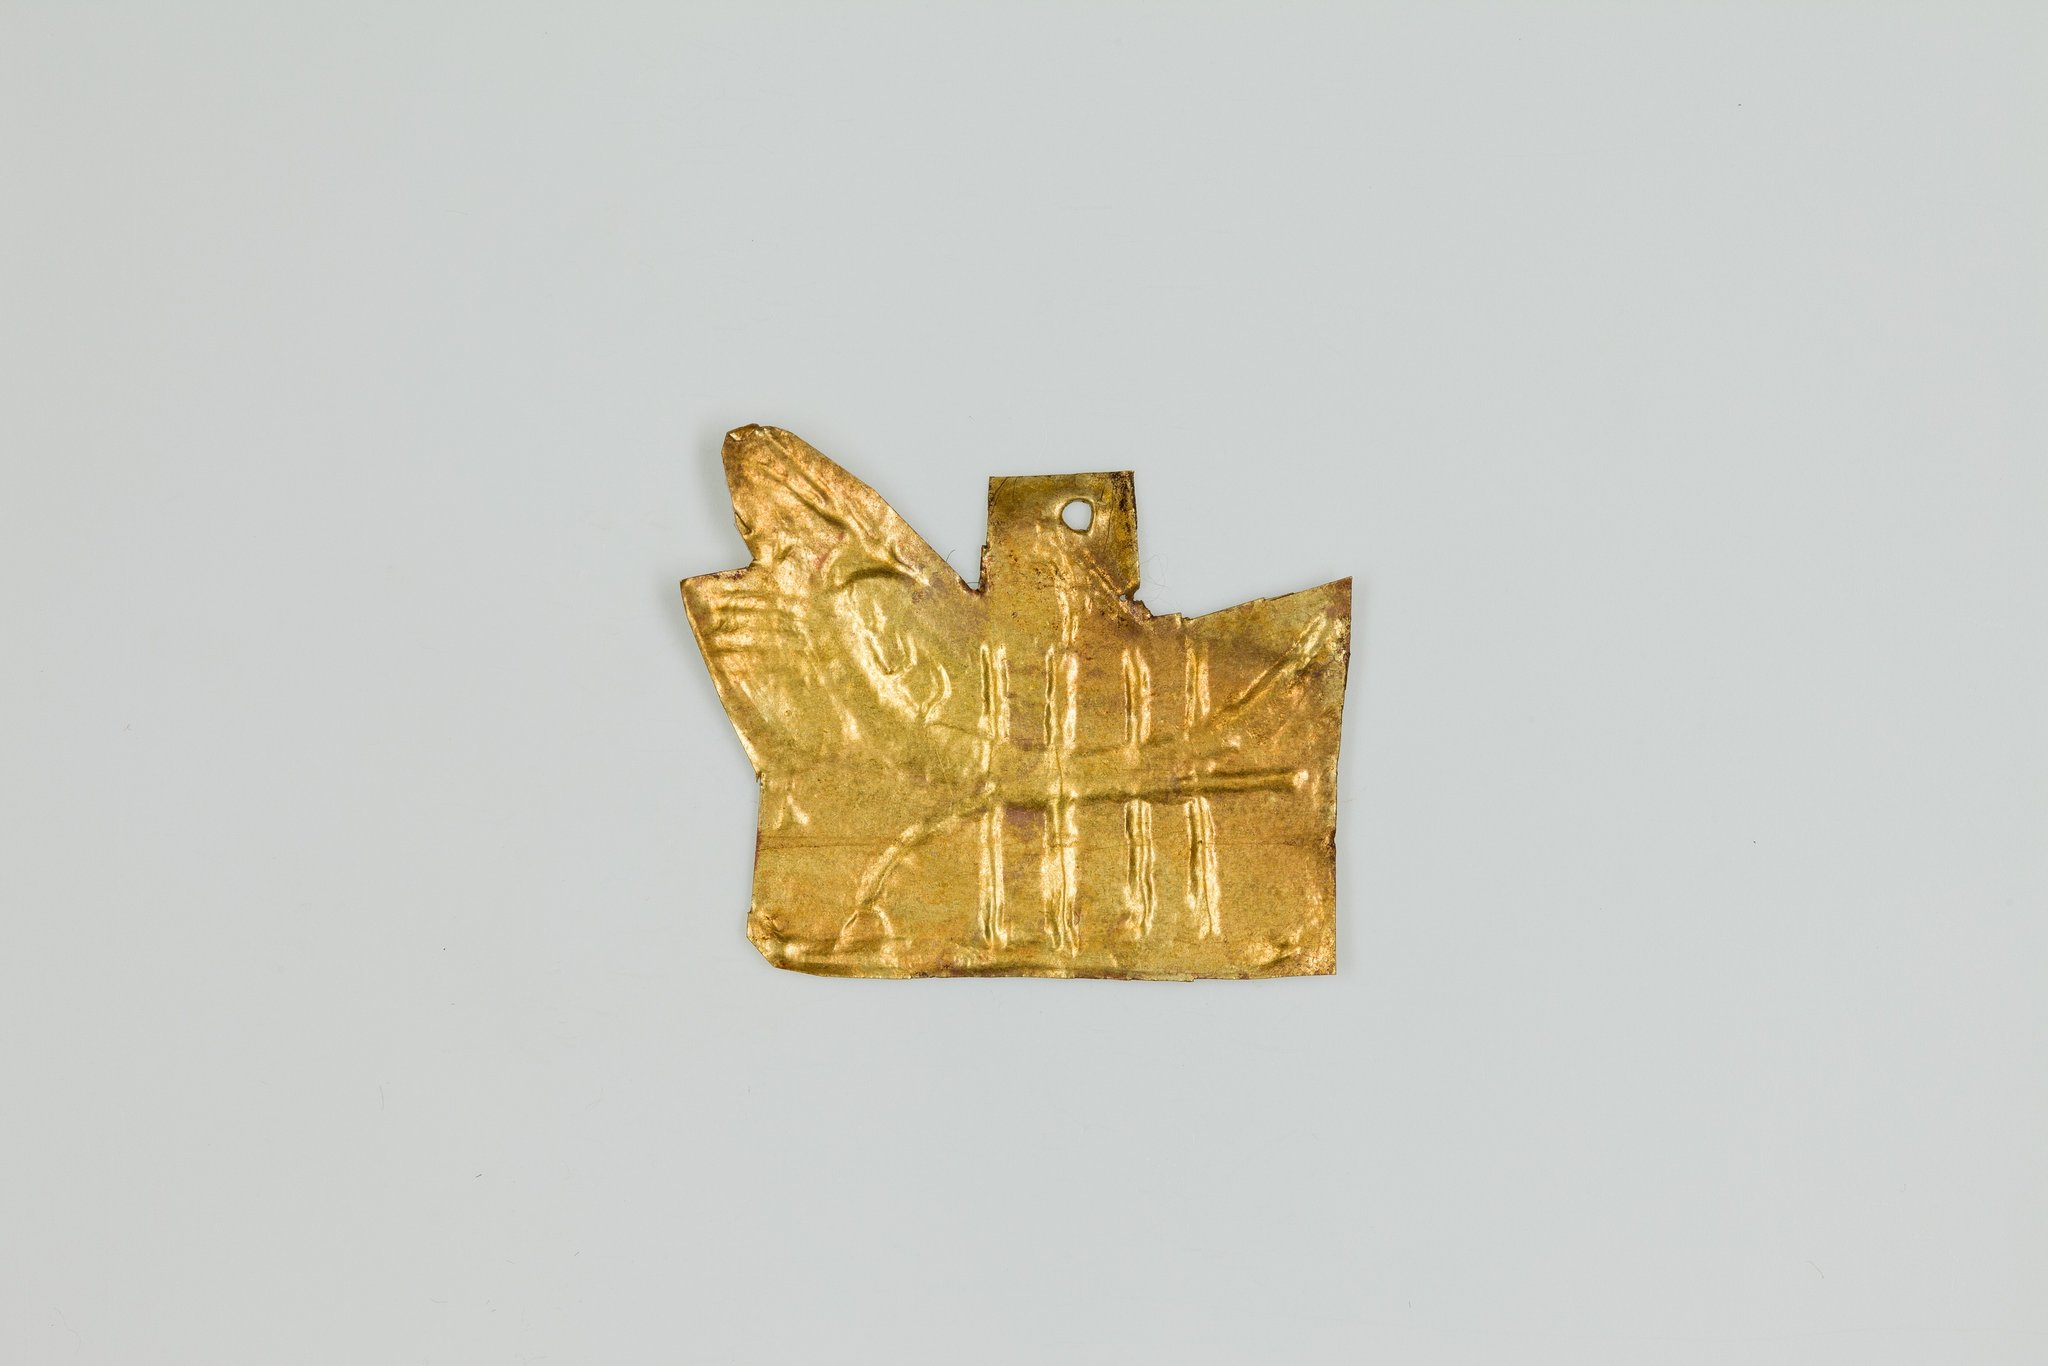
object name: amulet, henu barque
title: Henu barque amulet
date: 664-380 BCE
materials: gold